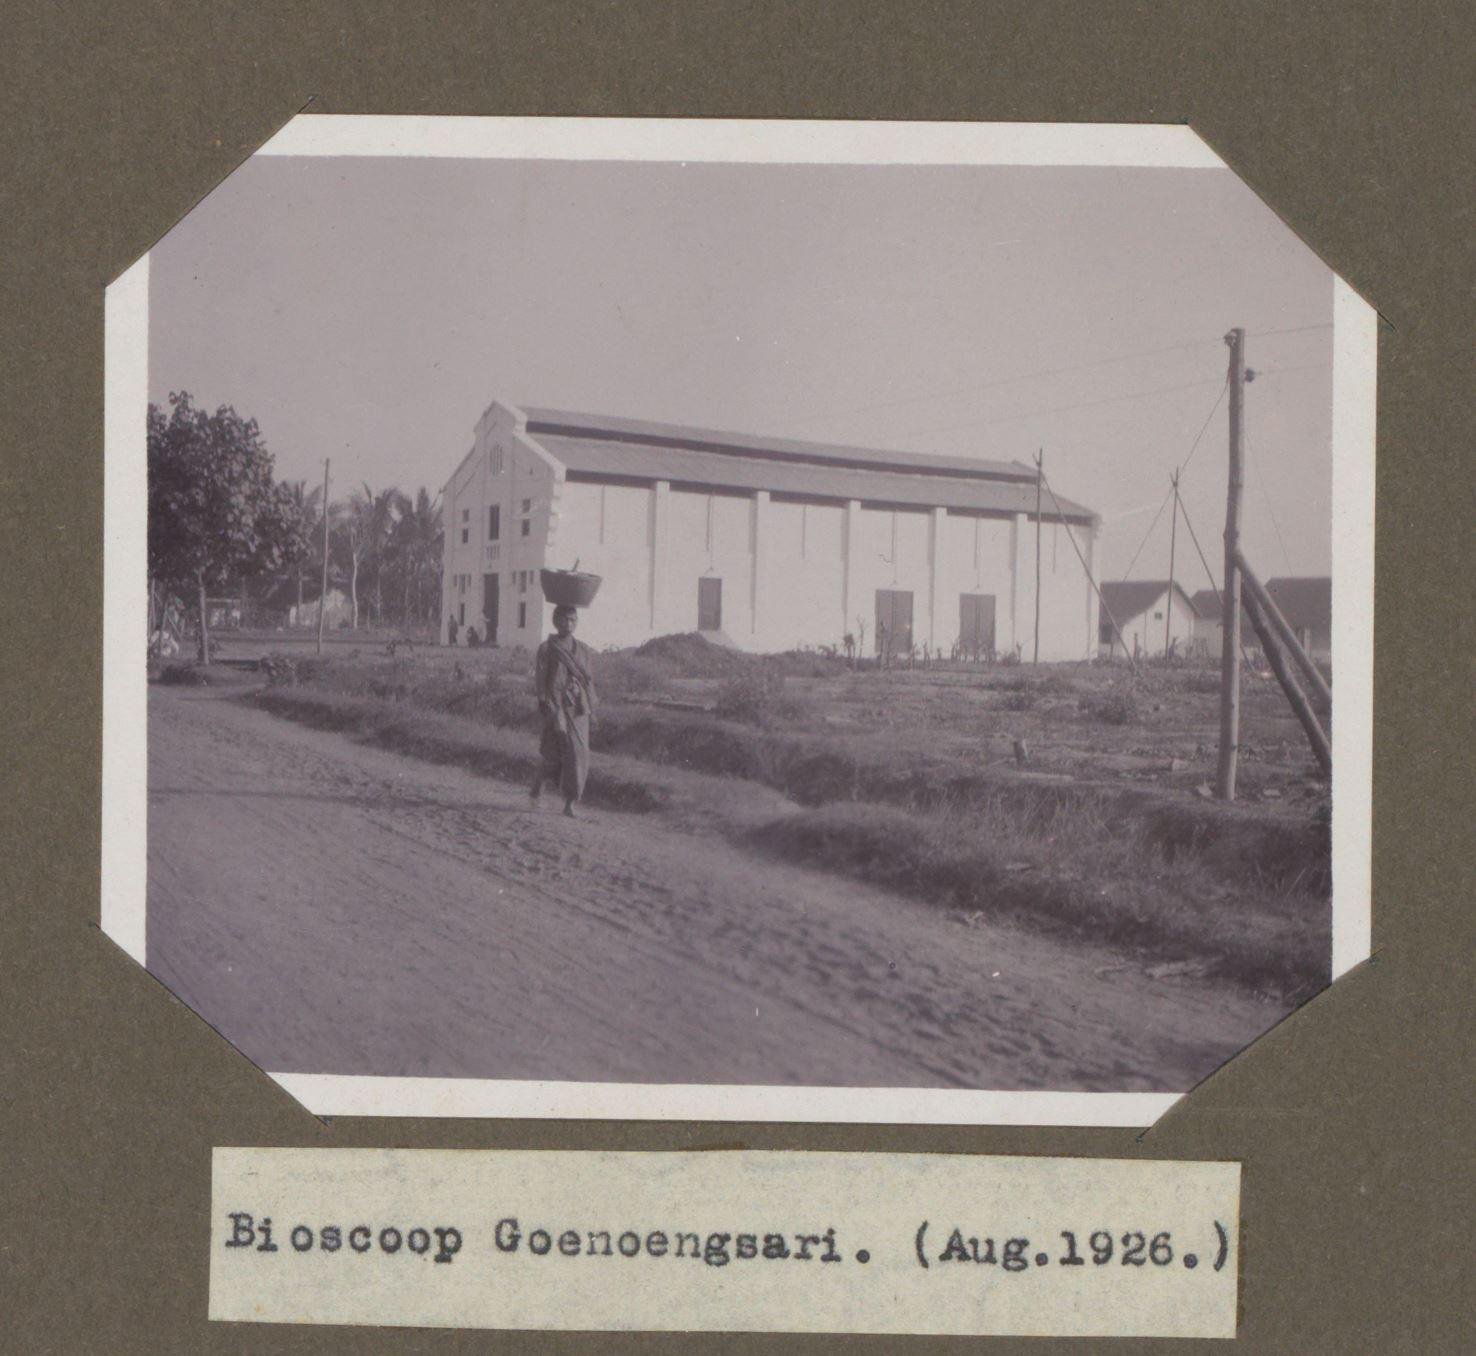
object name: photograph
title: Bioscoop Goenoengsari. (Aug. 1926.)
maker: Anonymous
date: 1908-1926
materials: photographic support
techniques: gelatin silver print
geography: east java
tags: colonial system, trade-company, cinema, movie-house, (non-fruit) products of plants or trees: sugarcane, representation of real building (either existing or having existed)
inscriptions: inscription: ‘Bioscoop Goenoengsari. (Aug. 1926.)’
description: Bioscoop op het fabrieksterrein, augustus 1926. Onderdeel van het fotoalbum met foto's van de opbouw van de suikerfabriek te Goenoengsari op Oost-Java door de Handels Vereniging Amsterdam 1926-1927.